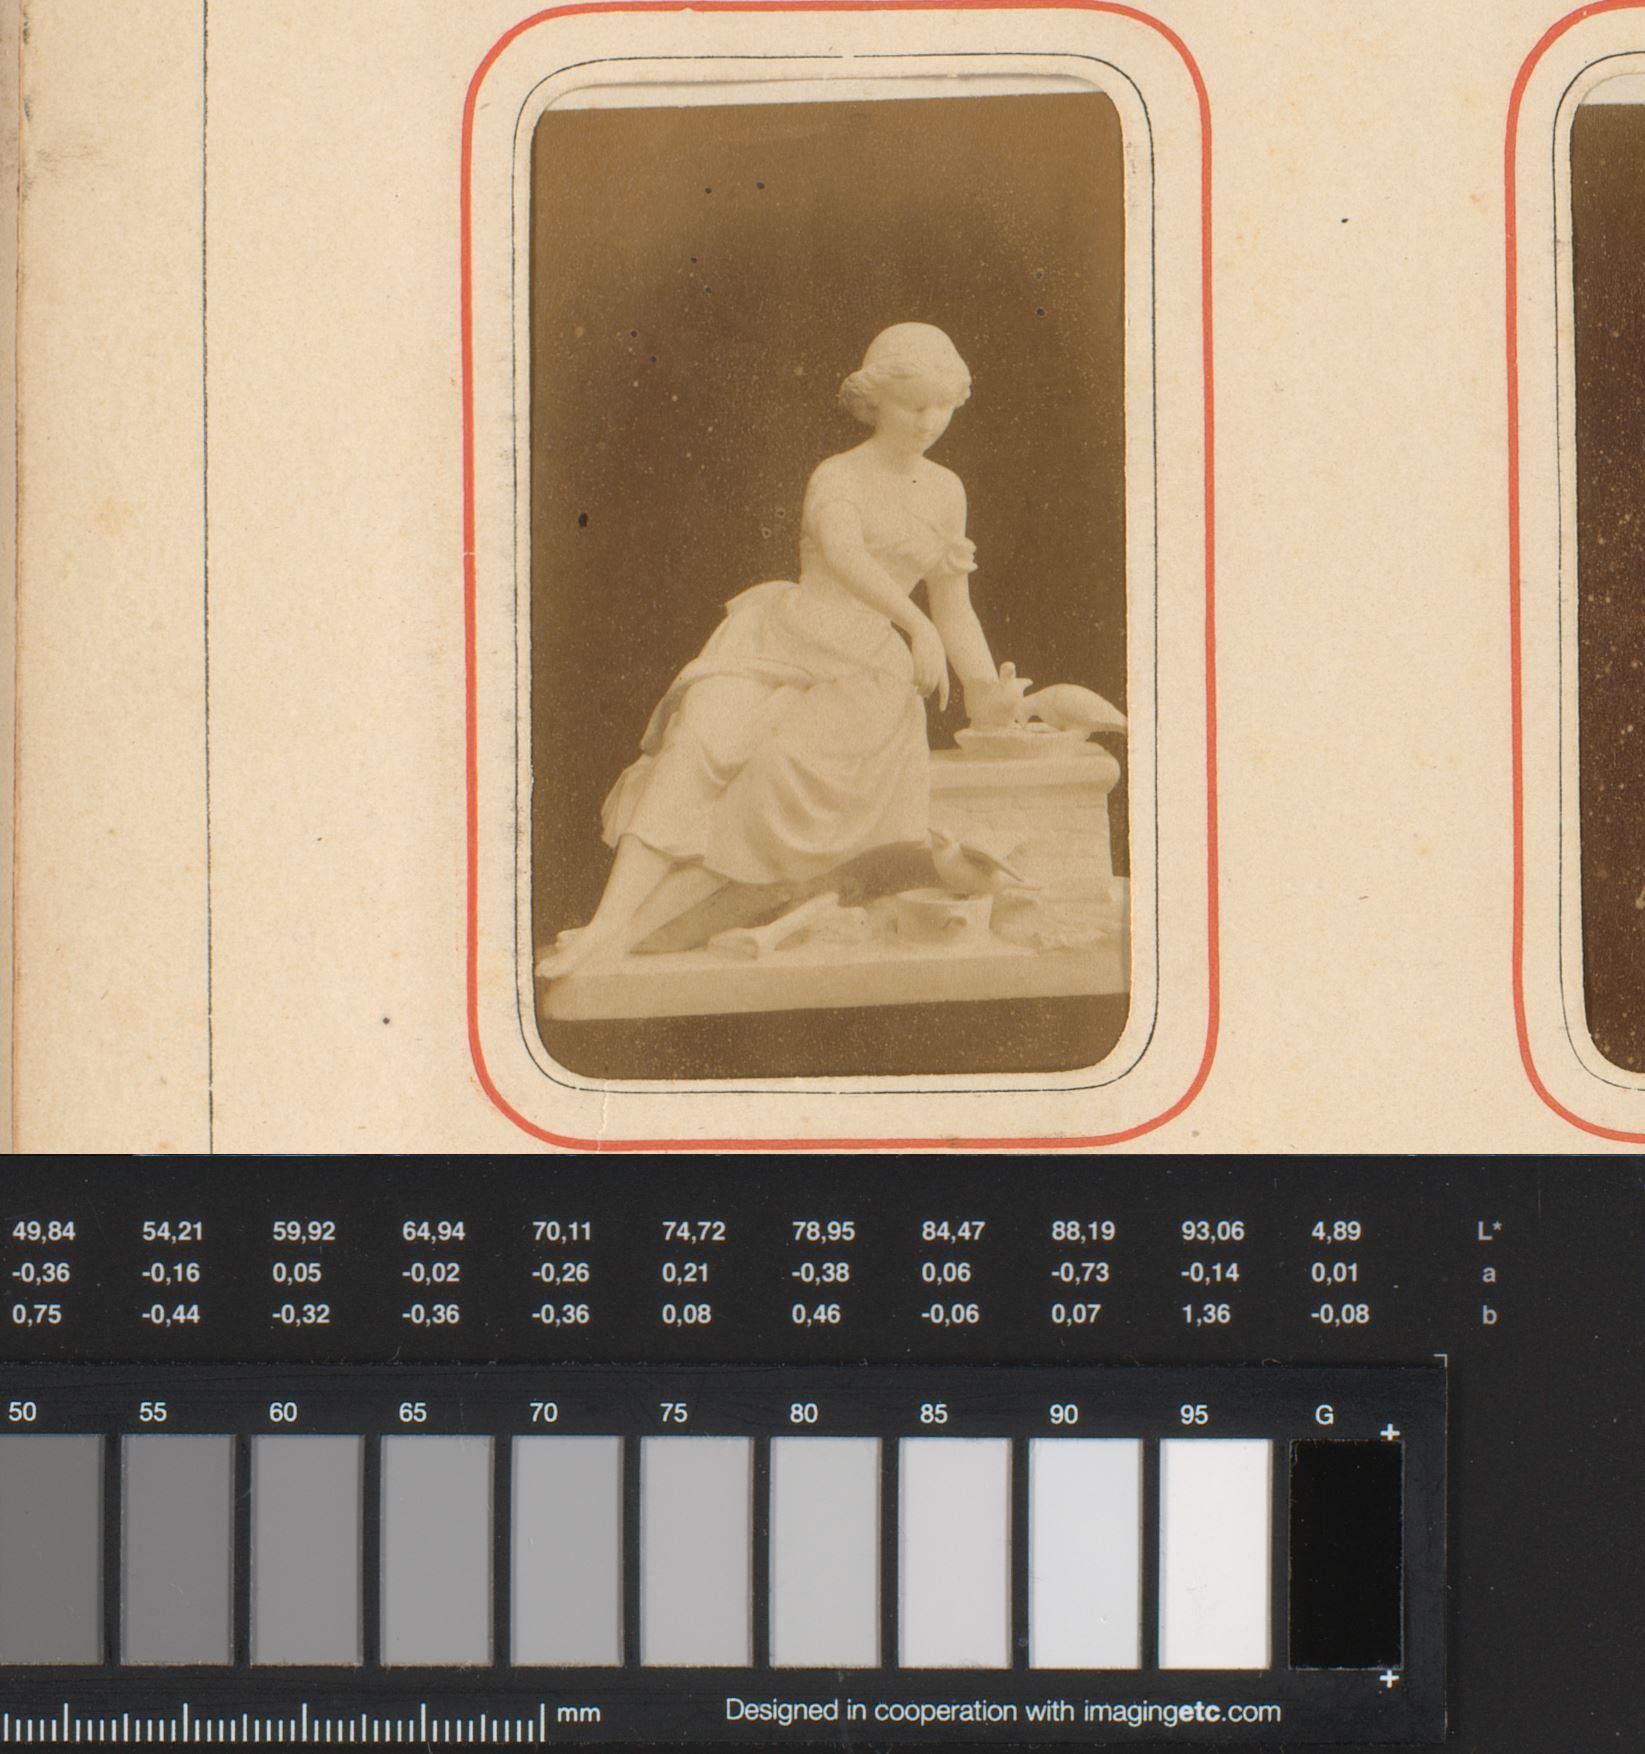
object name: reproduction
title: Aschenputtel, nach Cauer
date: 1870-1890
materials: cardboard, paper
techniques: albumen print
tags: sculpture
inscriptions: number: ‘461.’